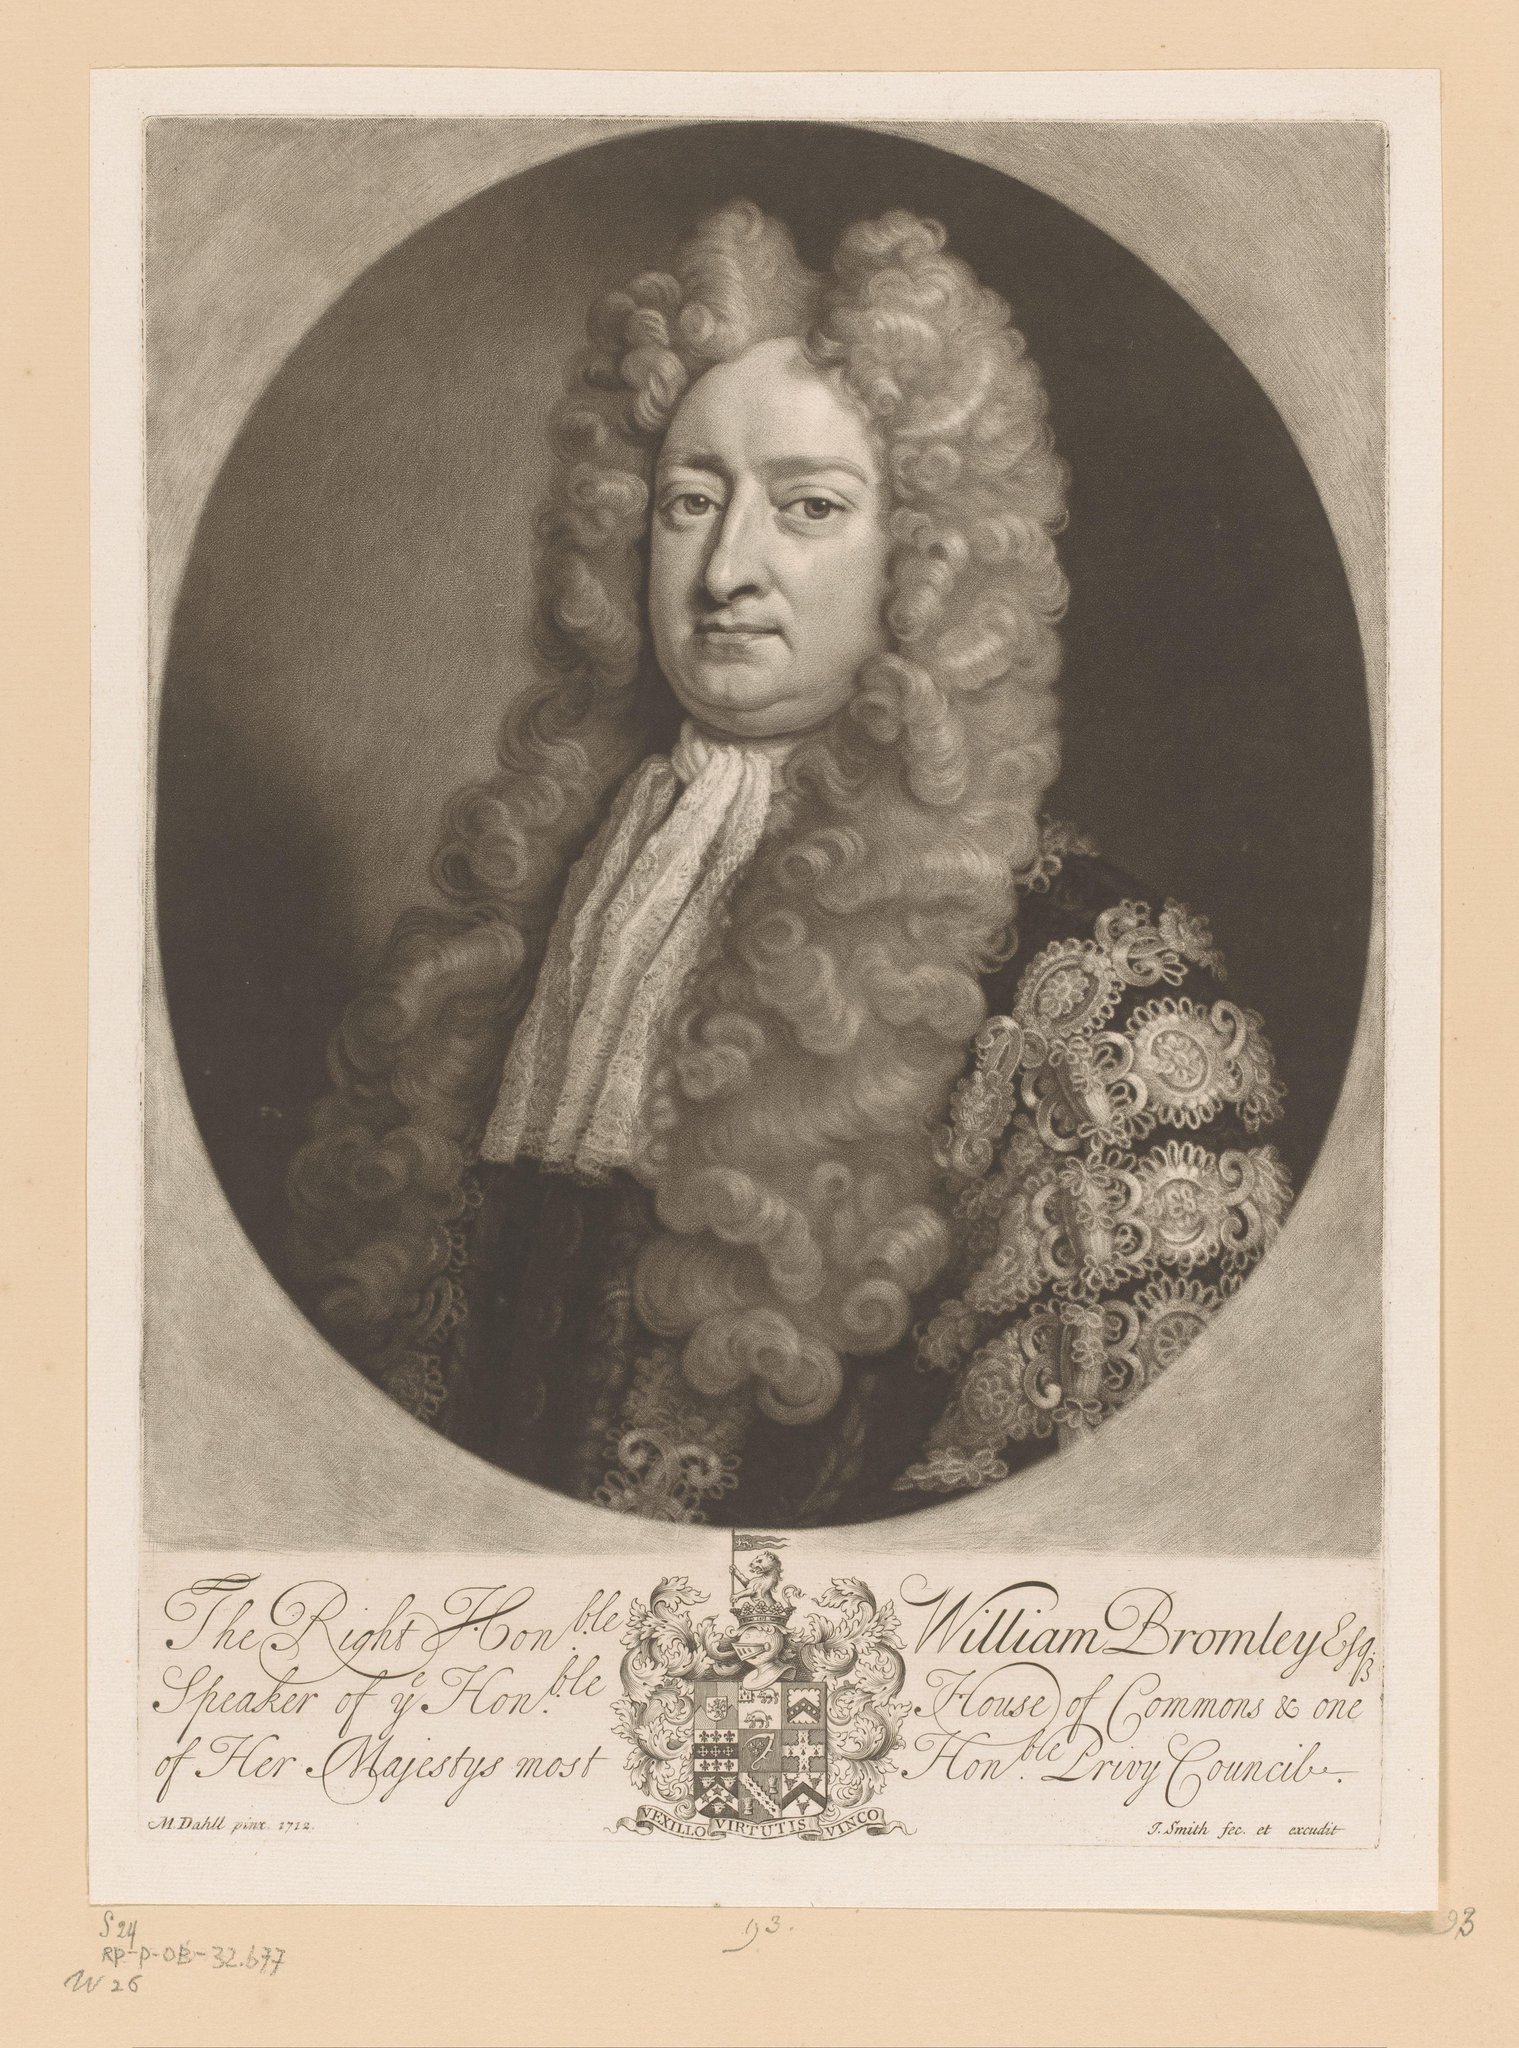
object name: print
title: Portret van William Bromley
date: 1712-1742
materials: paper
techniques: mezzotint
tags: politician, historical persons, politician, e.g. party leader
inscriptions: collector's mark: Lugt 240